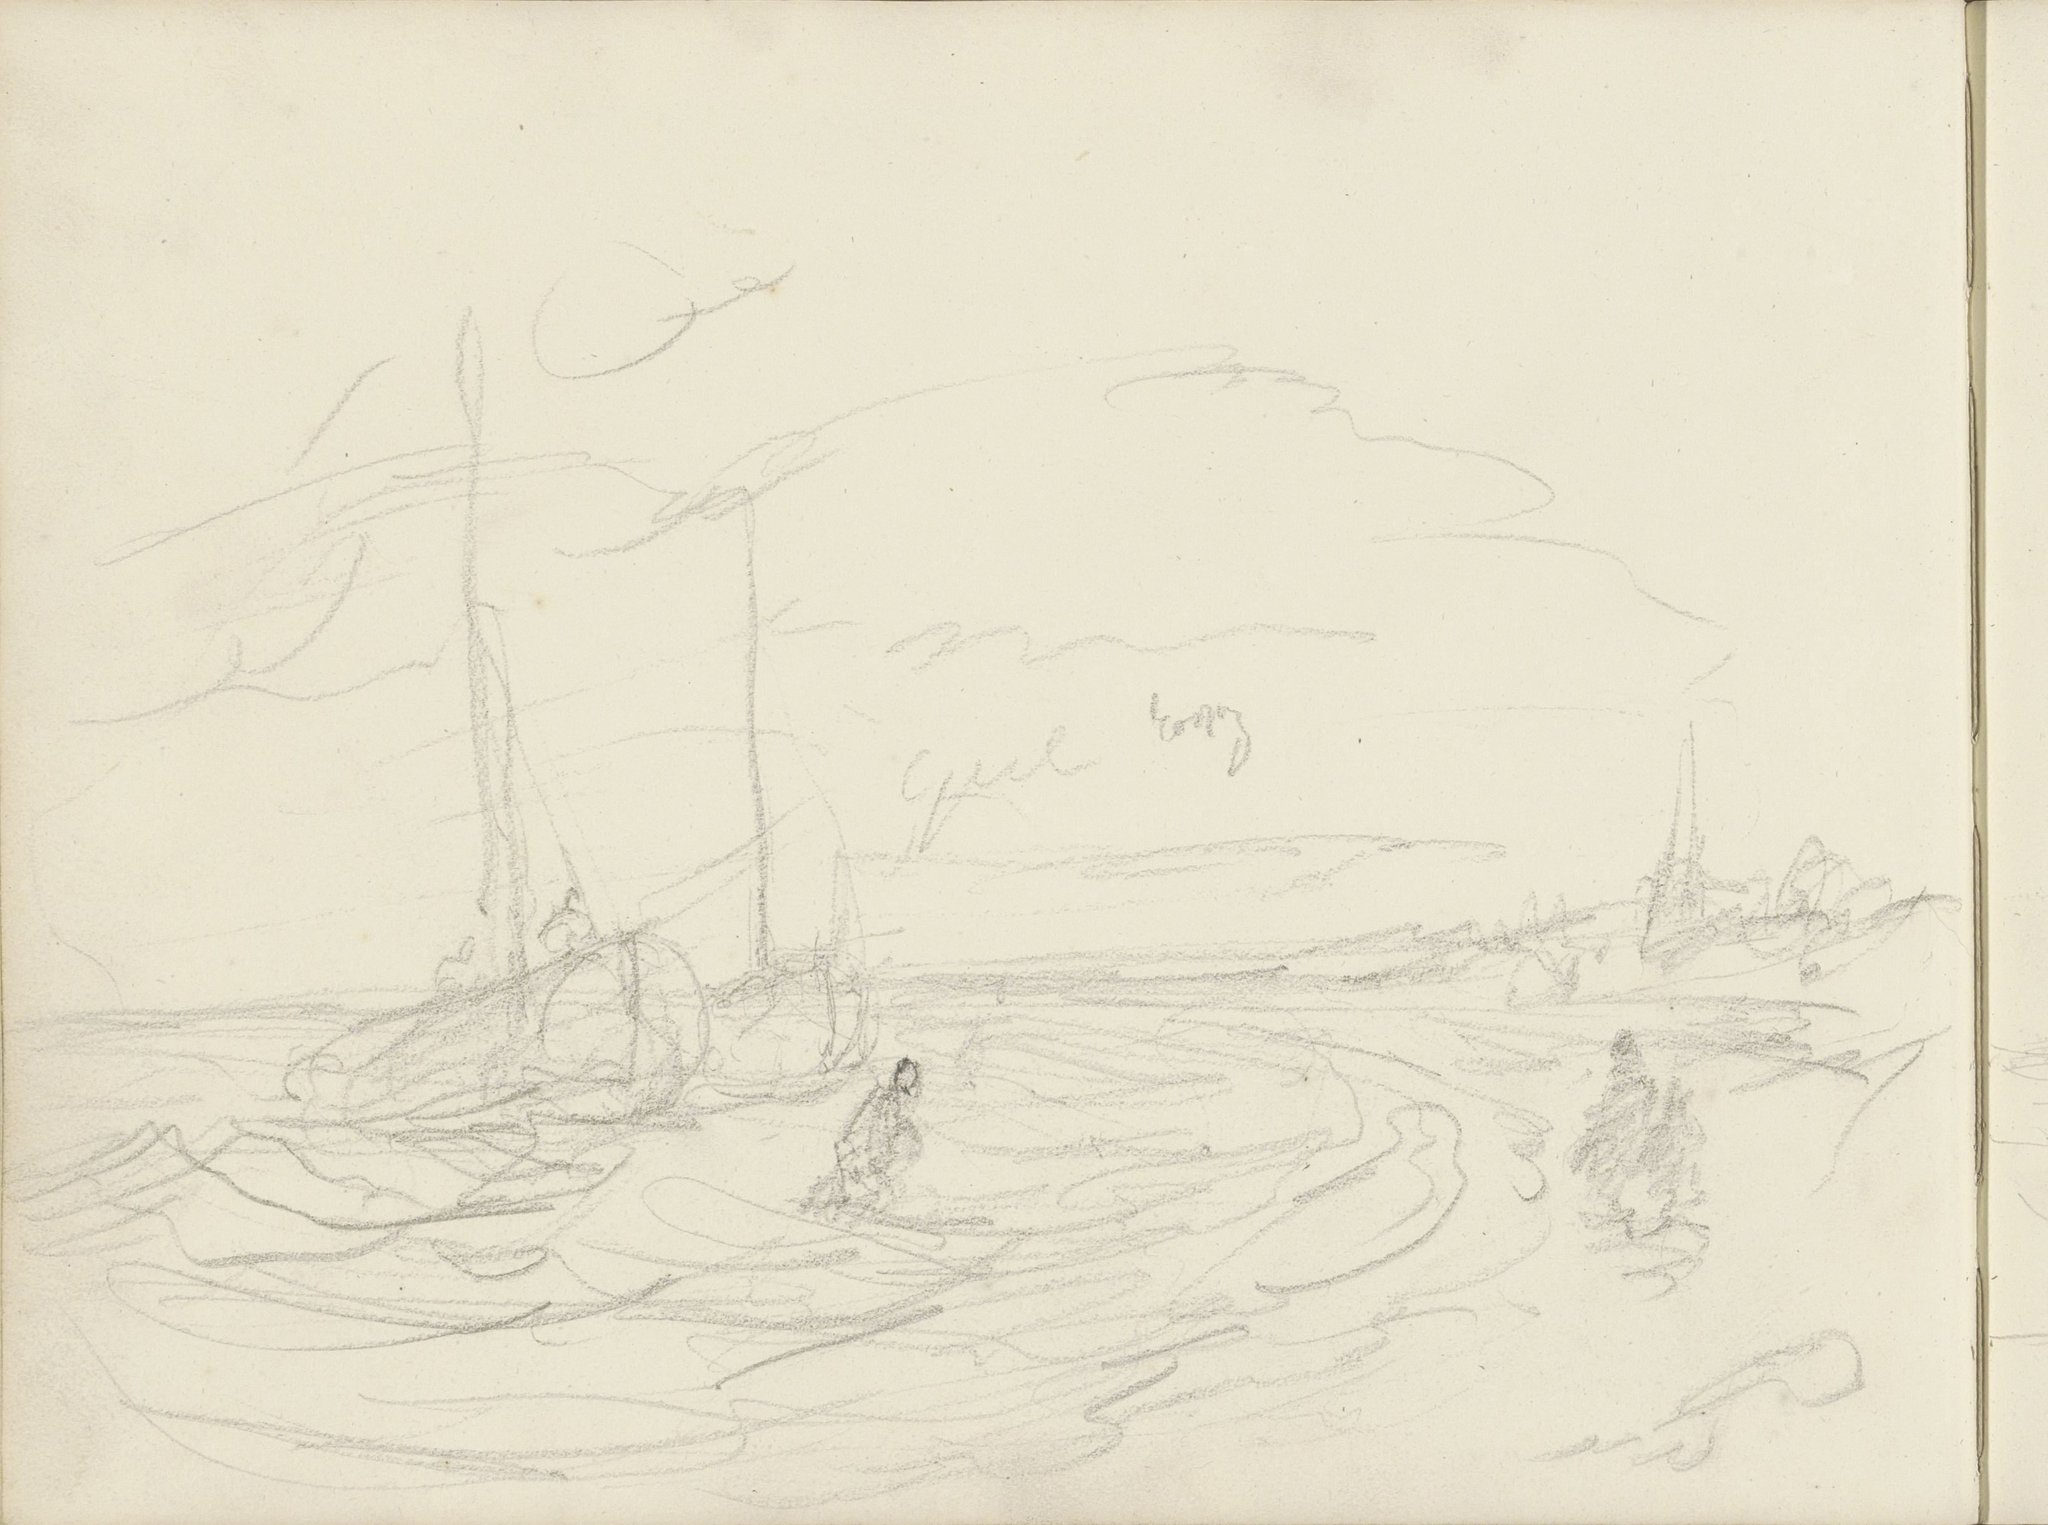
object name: sketchbook leaf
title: Afgemeerde boten voor een kust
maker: petrus johannes schotel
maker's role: draughtsman, painter, print maker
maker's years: 1808-1865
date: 1825-1875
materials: paper, pencil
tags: prospect of village, silhouette of village, coast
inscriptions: kleurnotitie, handgeschreven in potlood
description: Op de achtergrond een torenspits en de contouren van een dorp. Blad 27 verso uit een schetsboek met 44 bladen.